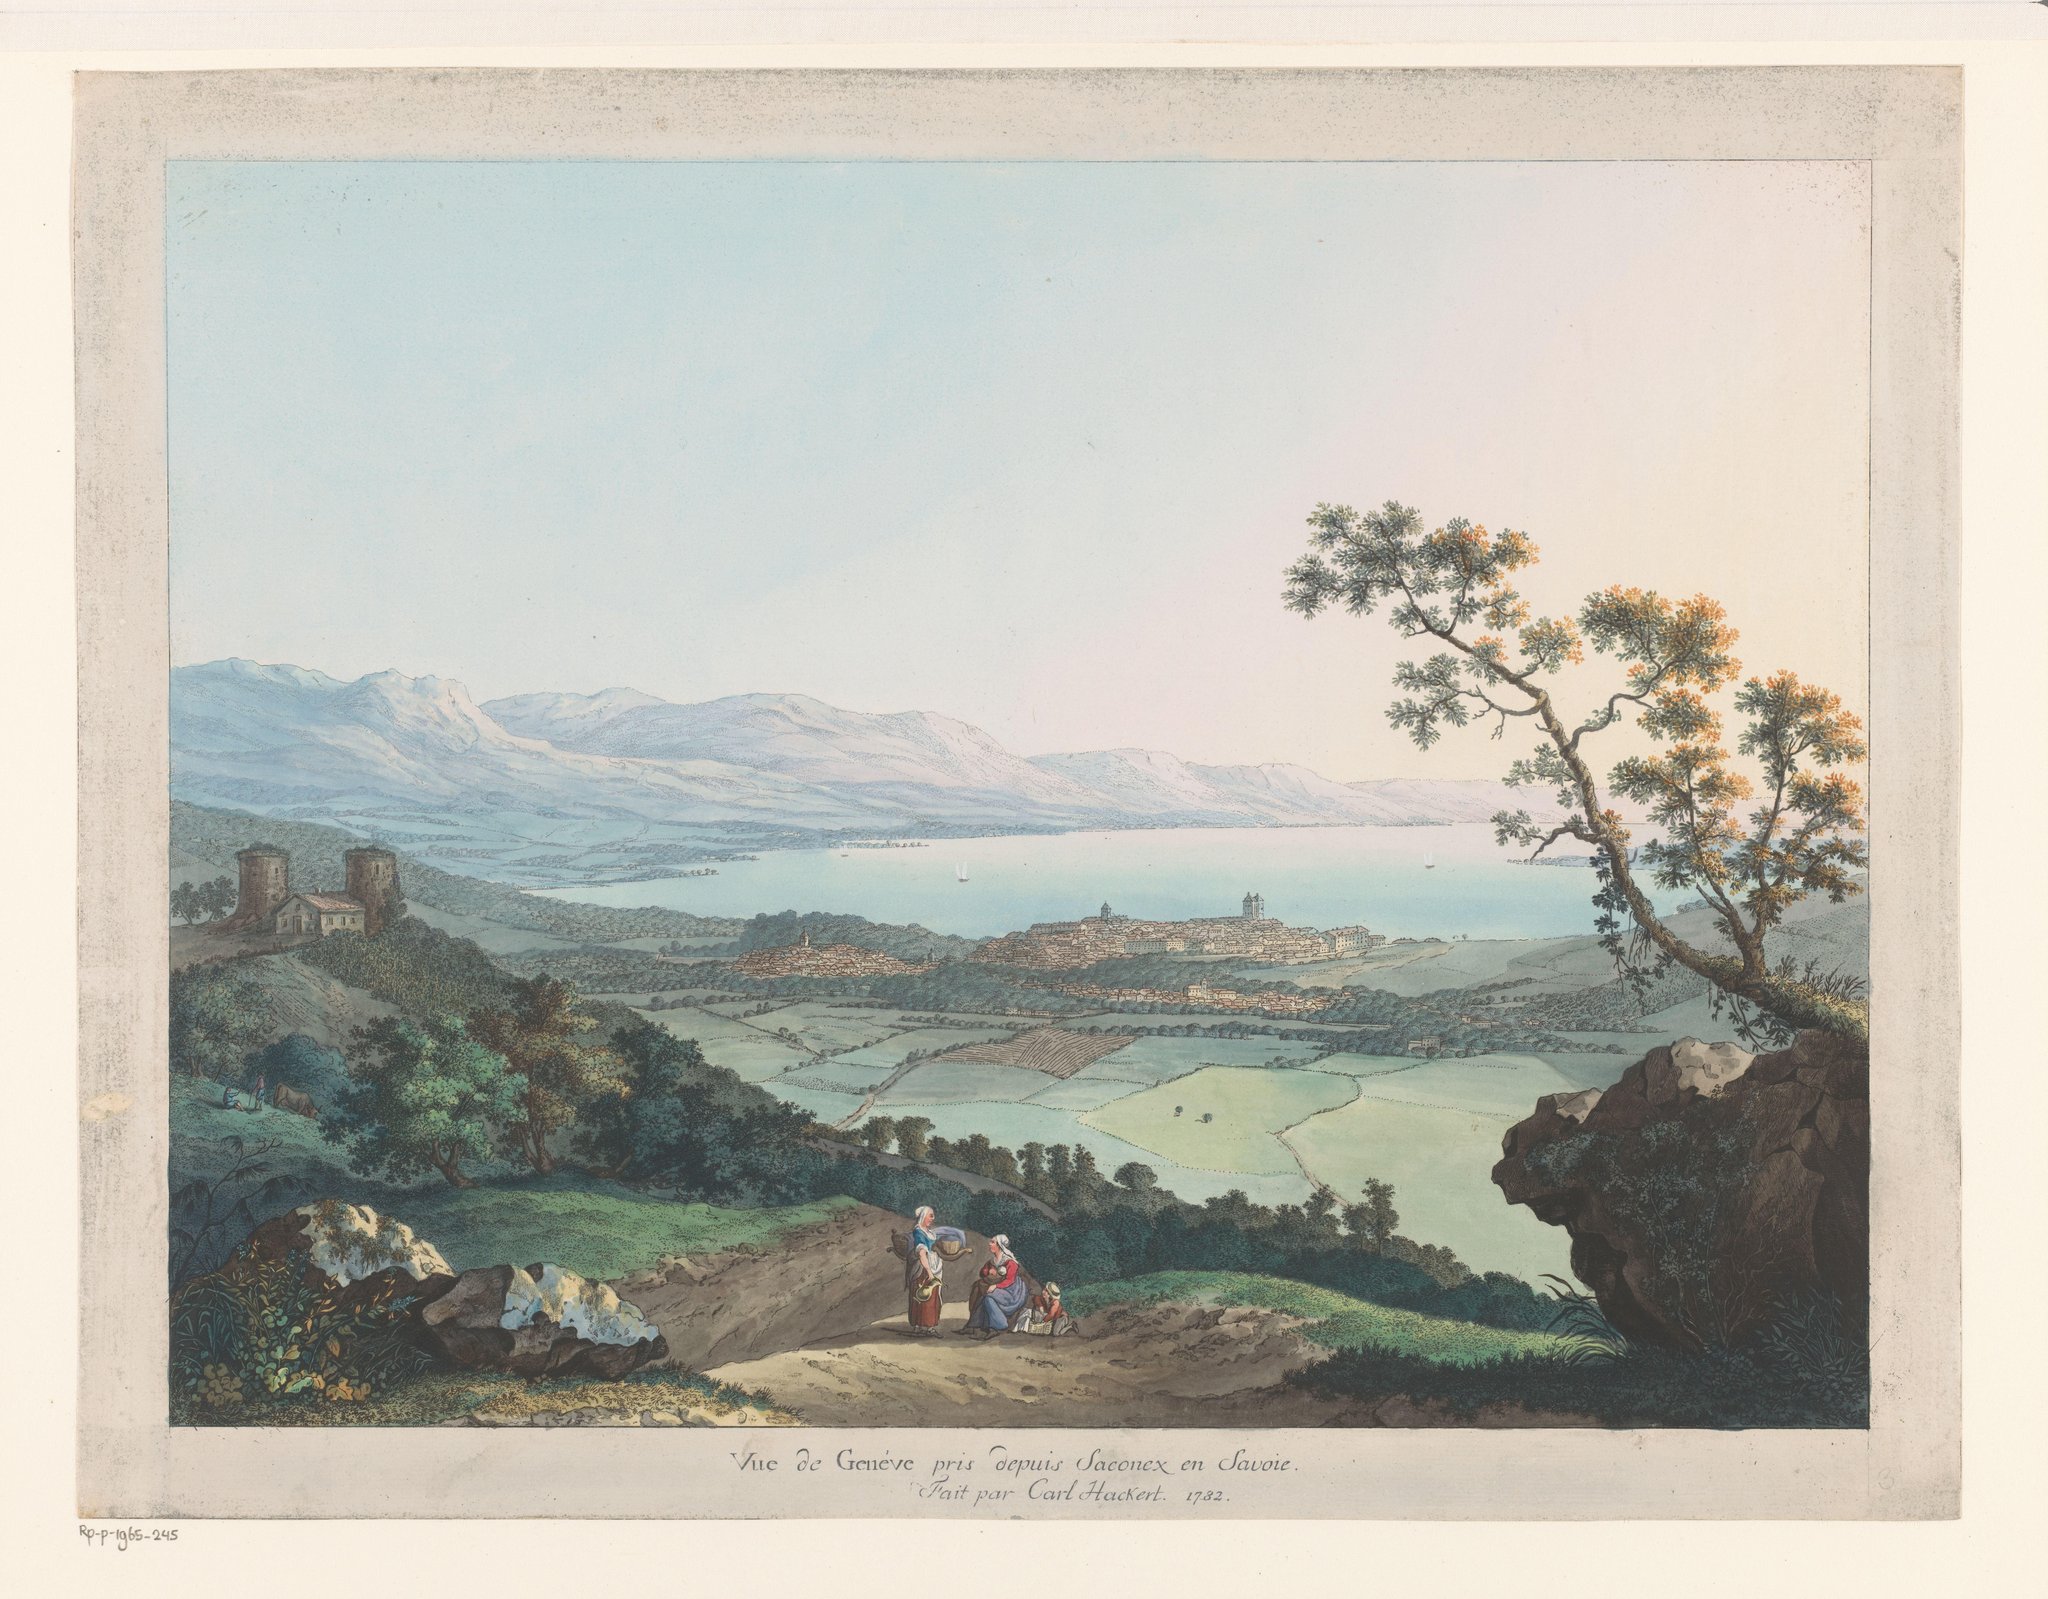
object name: print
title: Gezicht op Genève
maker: carl ludwig hackert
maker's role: print maker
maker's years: 1740-1796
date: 1782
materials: paper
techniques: aquatint, etching, hand coloring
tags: city-view in general; 'veduta', lake (+ landscape with figures, staffage), mountains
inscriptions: collector's mark: Lugt 2228